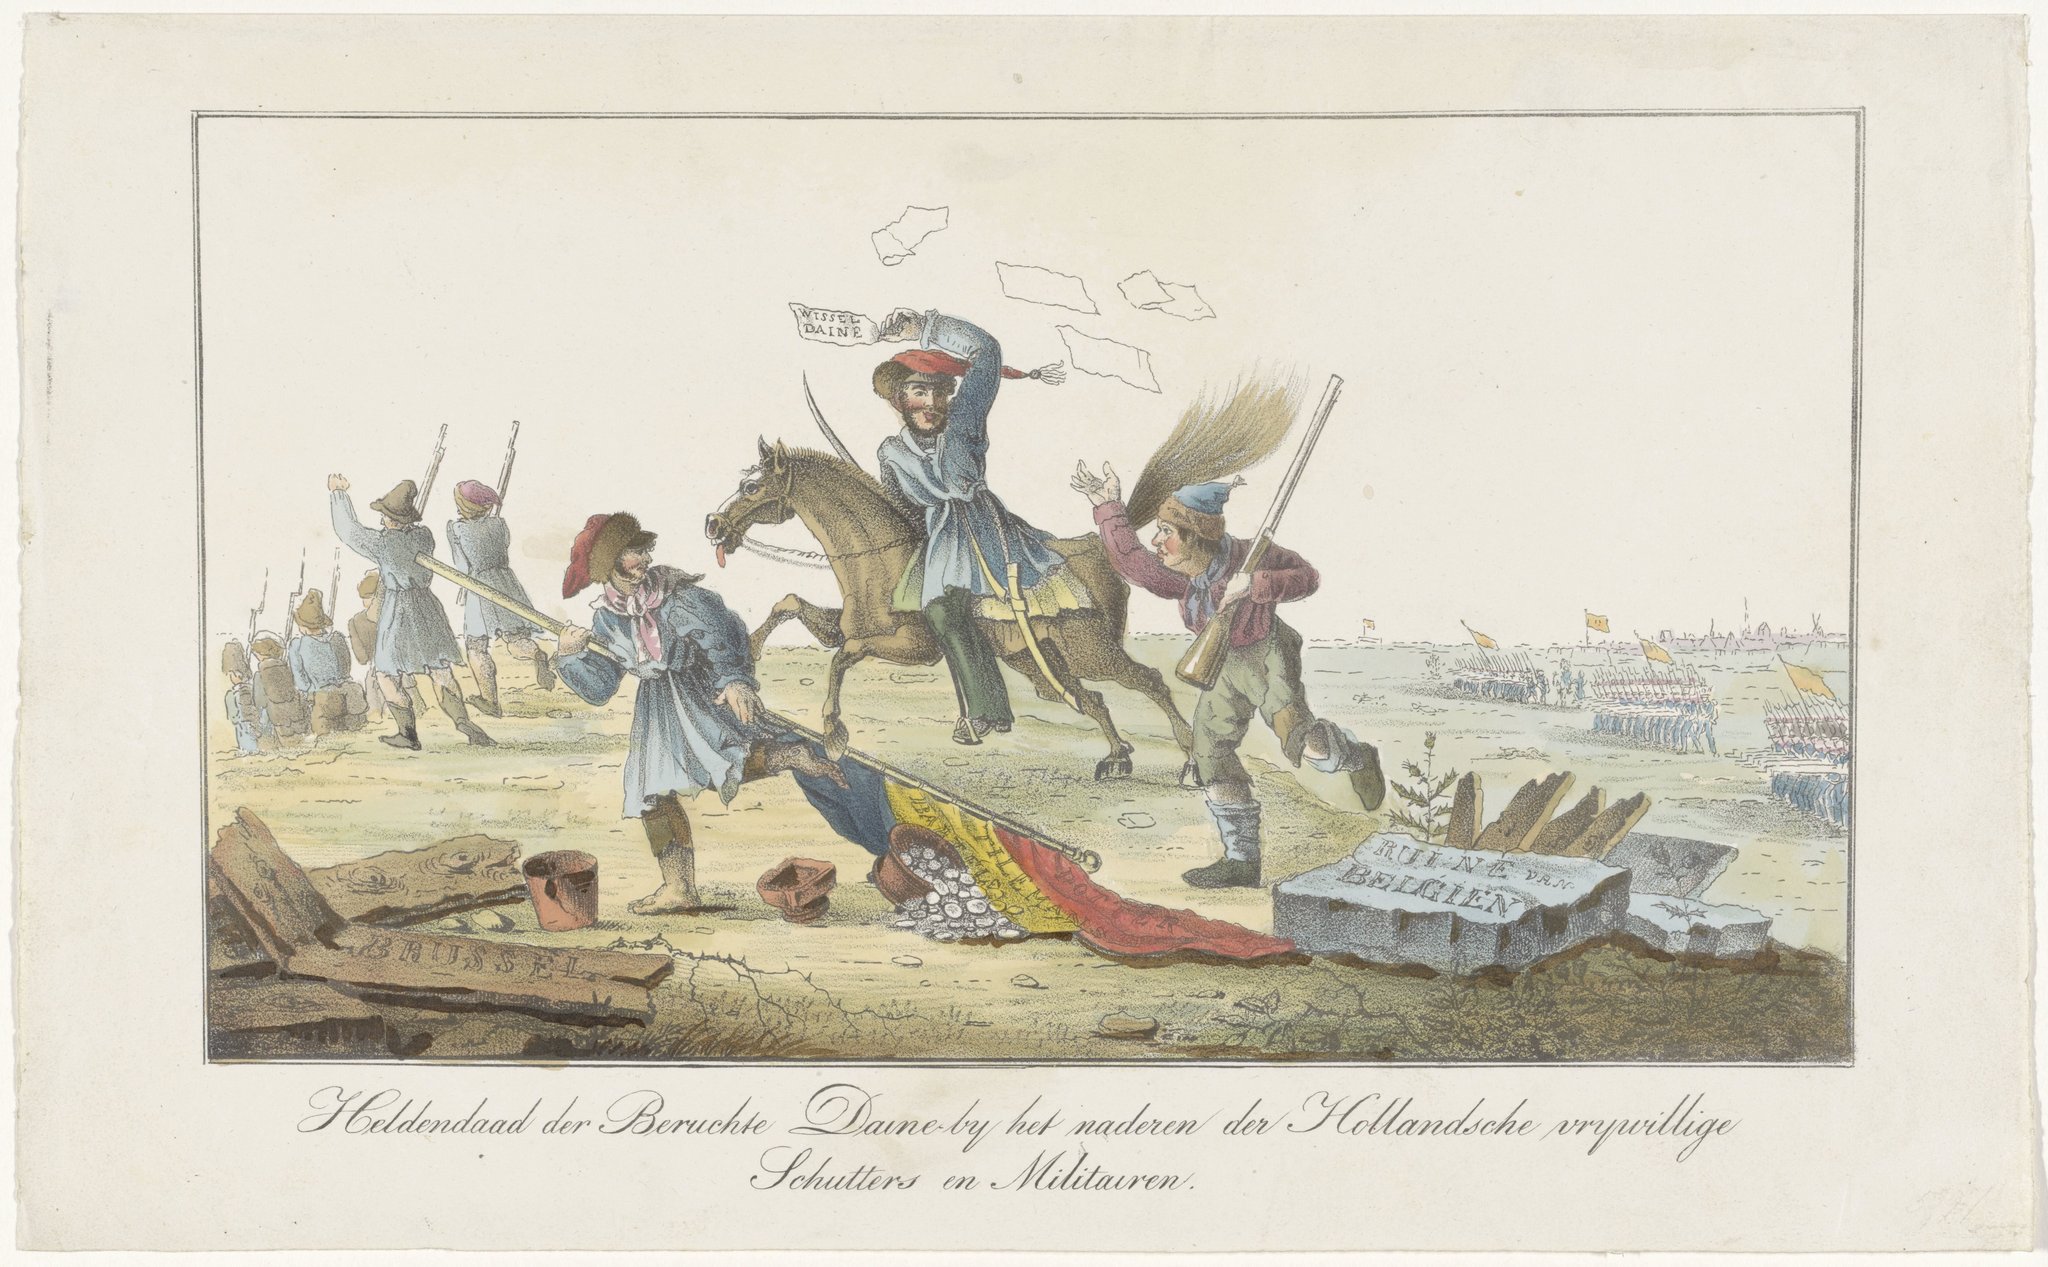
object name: cartoon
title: Heldendaad der Beruchte Daine bij het naderen der Hollandsche vrijwillige Schutters en Militairen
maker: Anonymous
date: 1831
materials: paper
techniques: hand coloring, lithograph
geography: netherlands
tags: putting the enemy to flight - hh - being put to flight, fleeing, retreat of the defeated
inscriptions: collector's mark: Lugt 2228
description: Spotprent op de vlucht van de Belgische generaal Daine, na zijn verlies in de slag bij Hasselt op 8 augustus 1831. Generaal Daine in blauwe kiel slaat met zijn manschappen op de vlucht en strooit onderweg met valse wissels, een militair sleept de Belgische vlag over de grond bij een aardewerken pot met geldstukken.